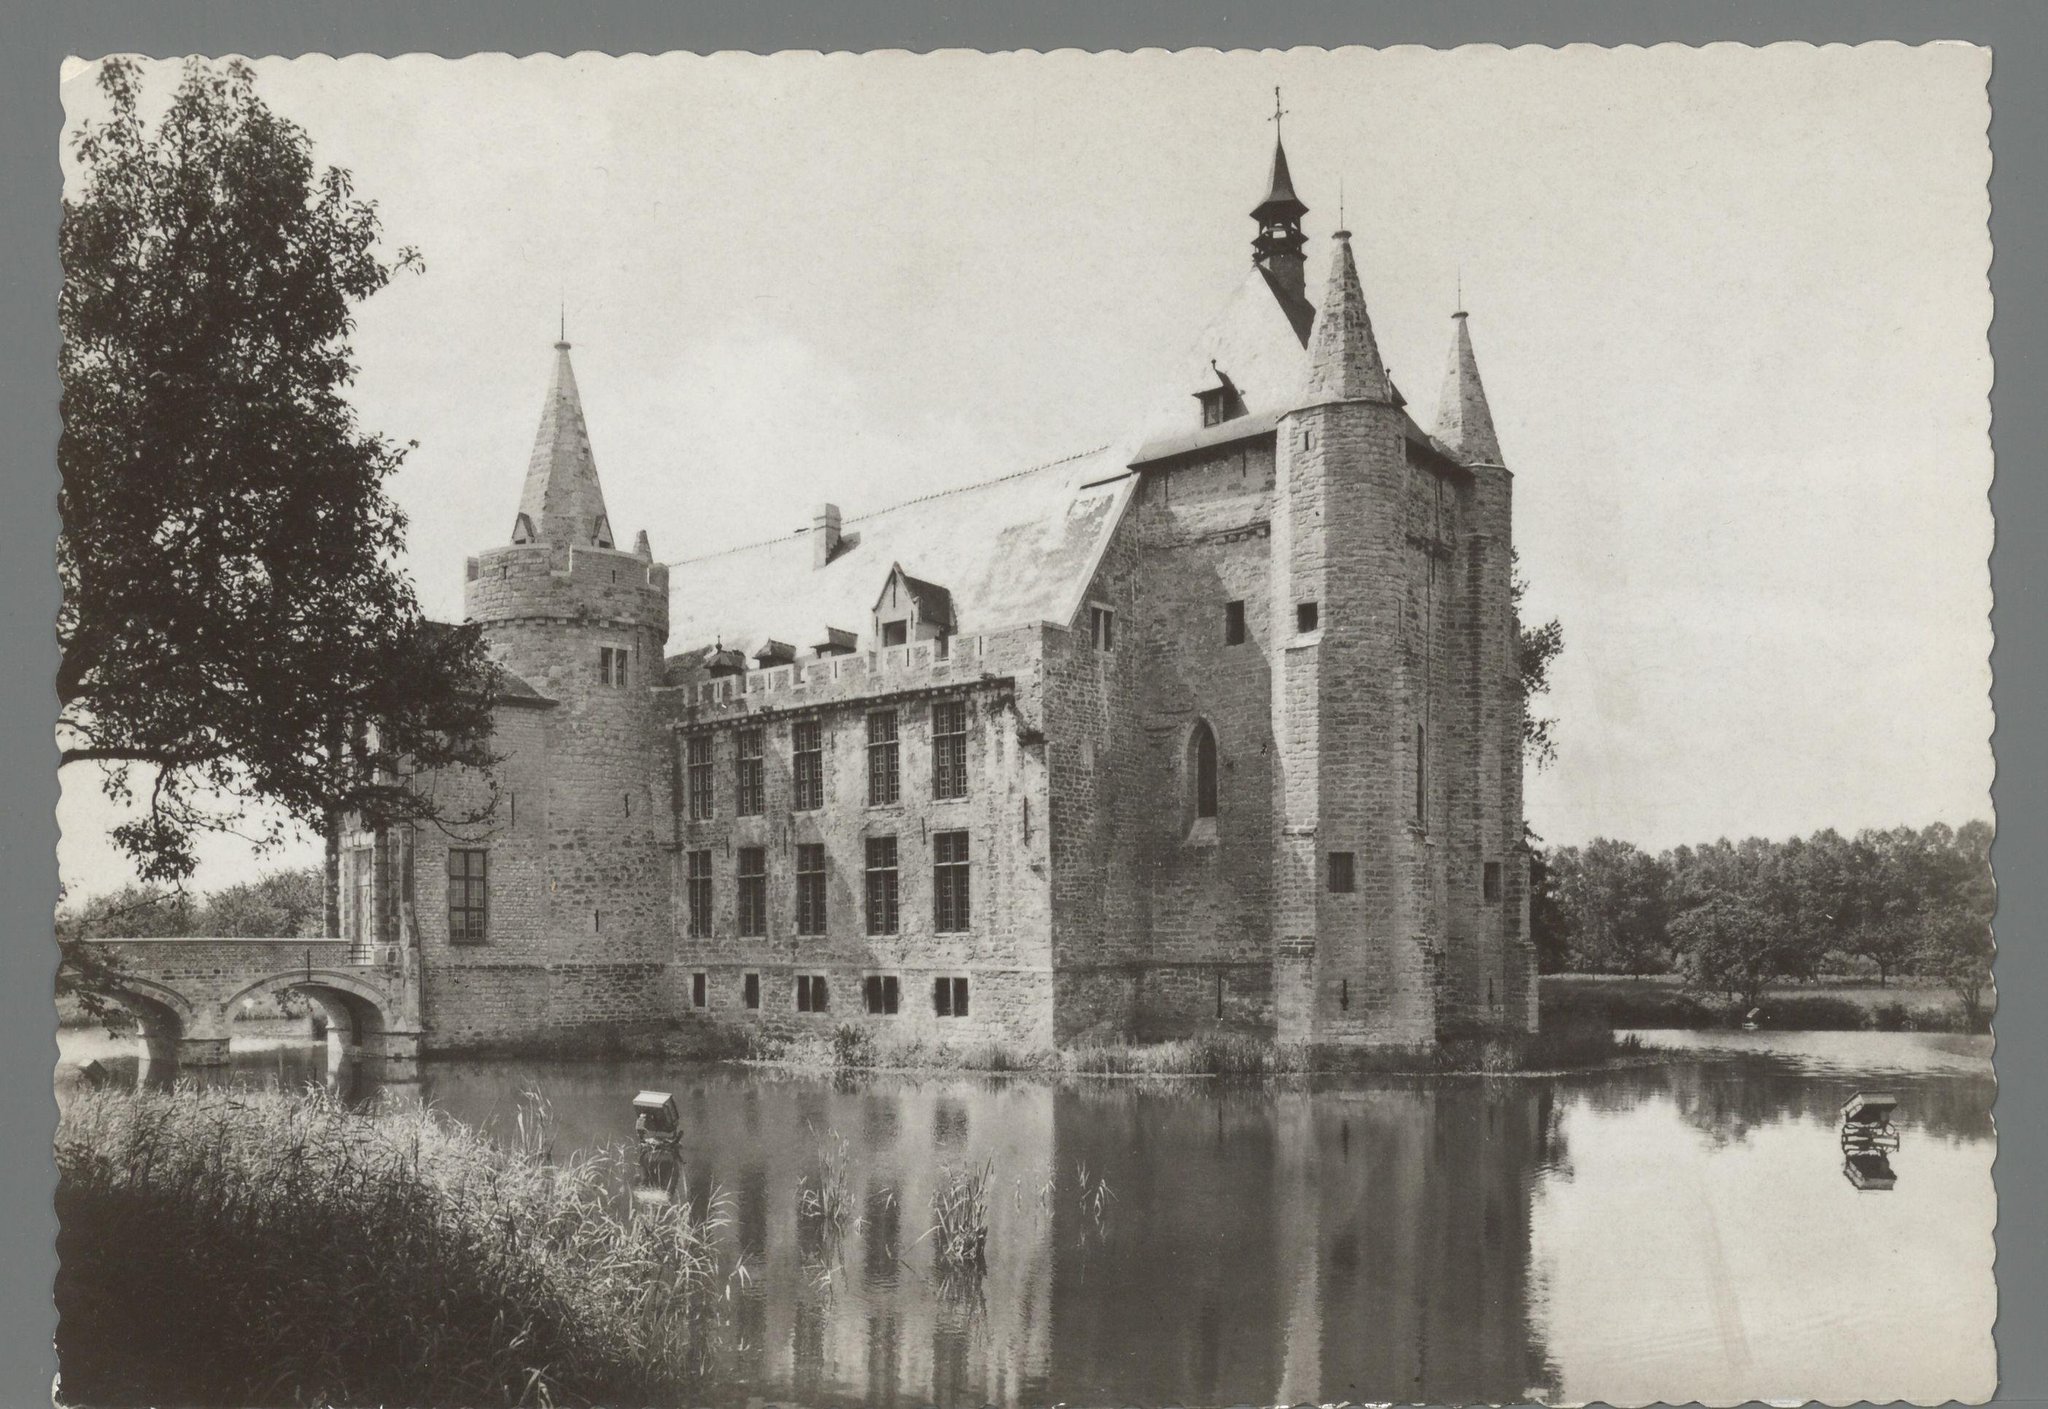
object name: photograph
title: Slot van Laarne / Château Féodal de Laarne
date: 1929-1975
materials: photographic support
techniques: photography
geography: stekene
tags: castle, canal